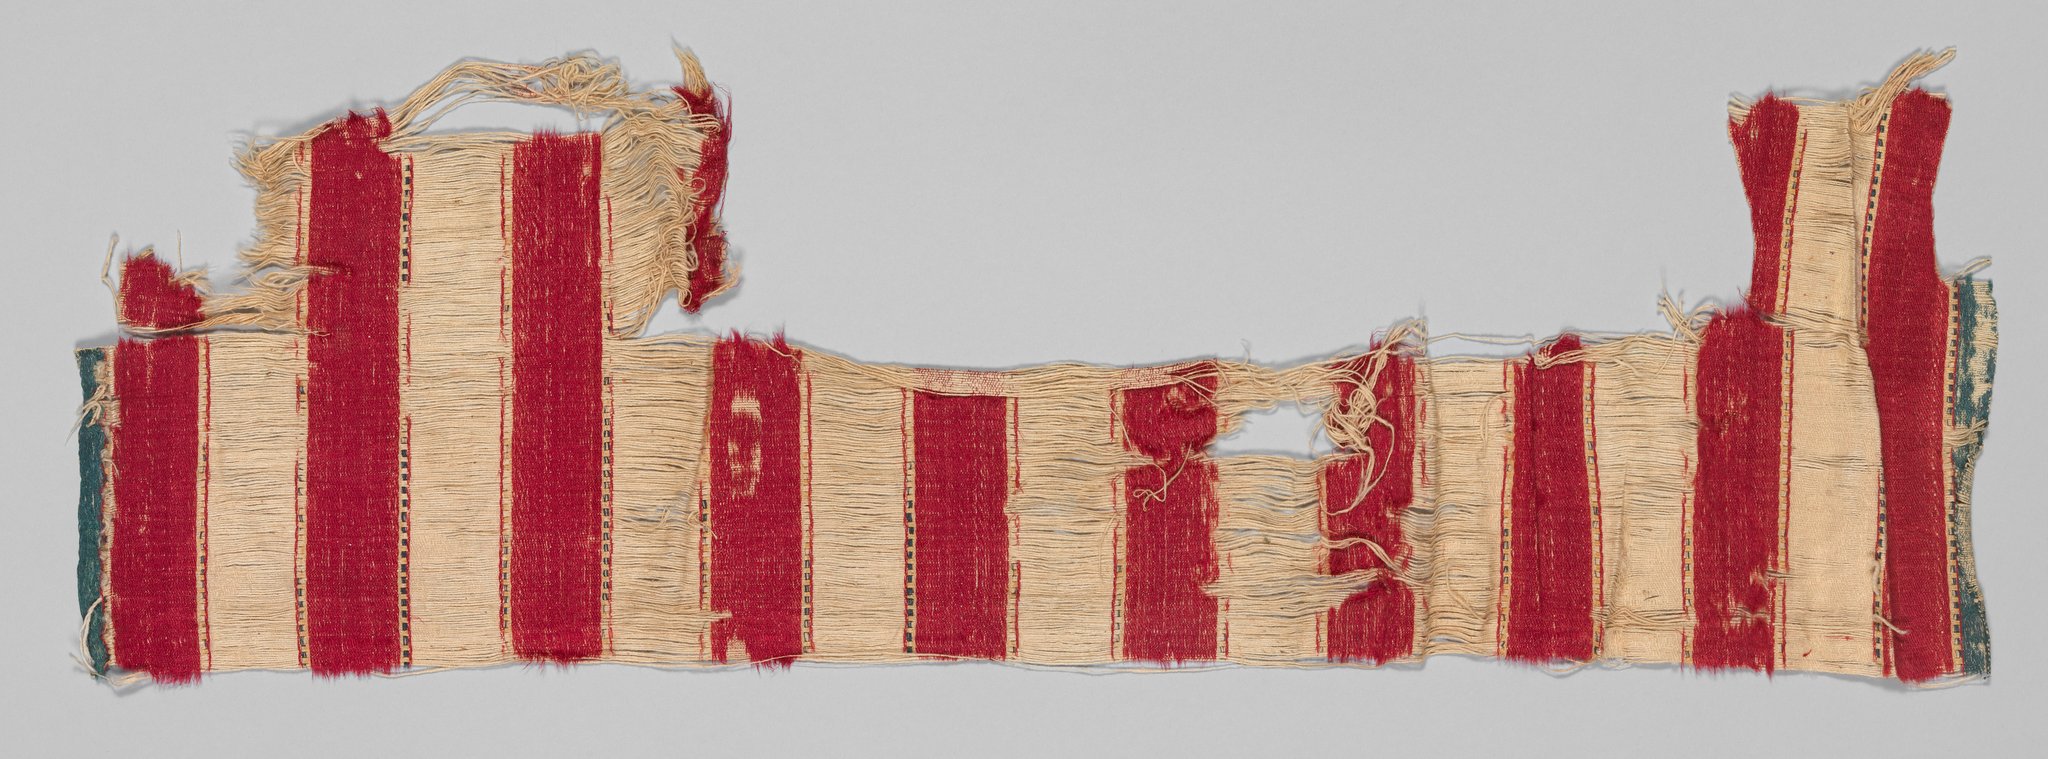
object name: textile fragment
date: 1801-1900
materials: textile, thread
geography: india